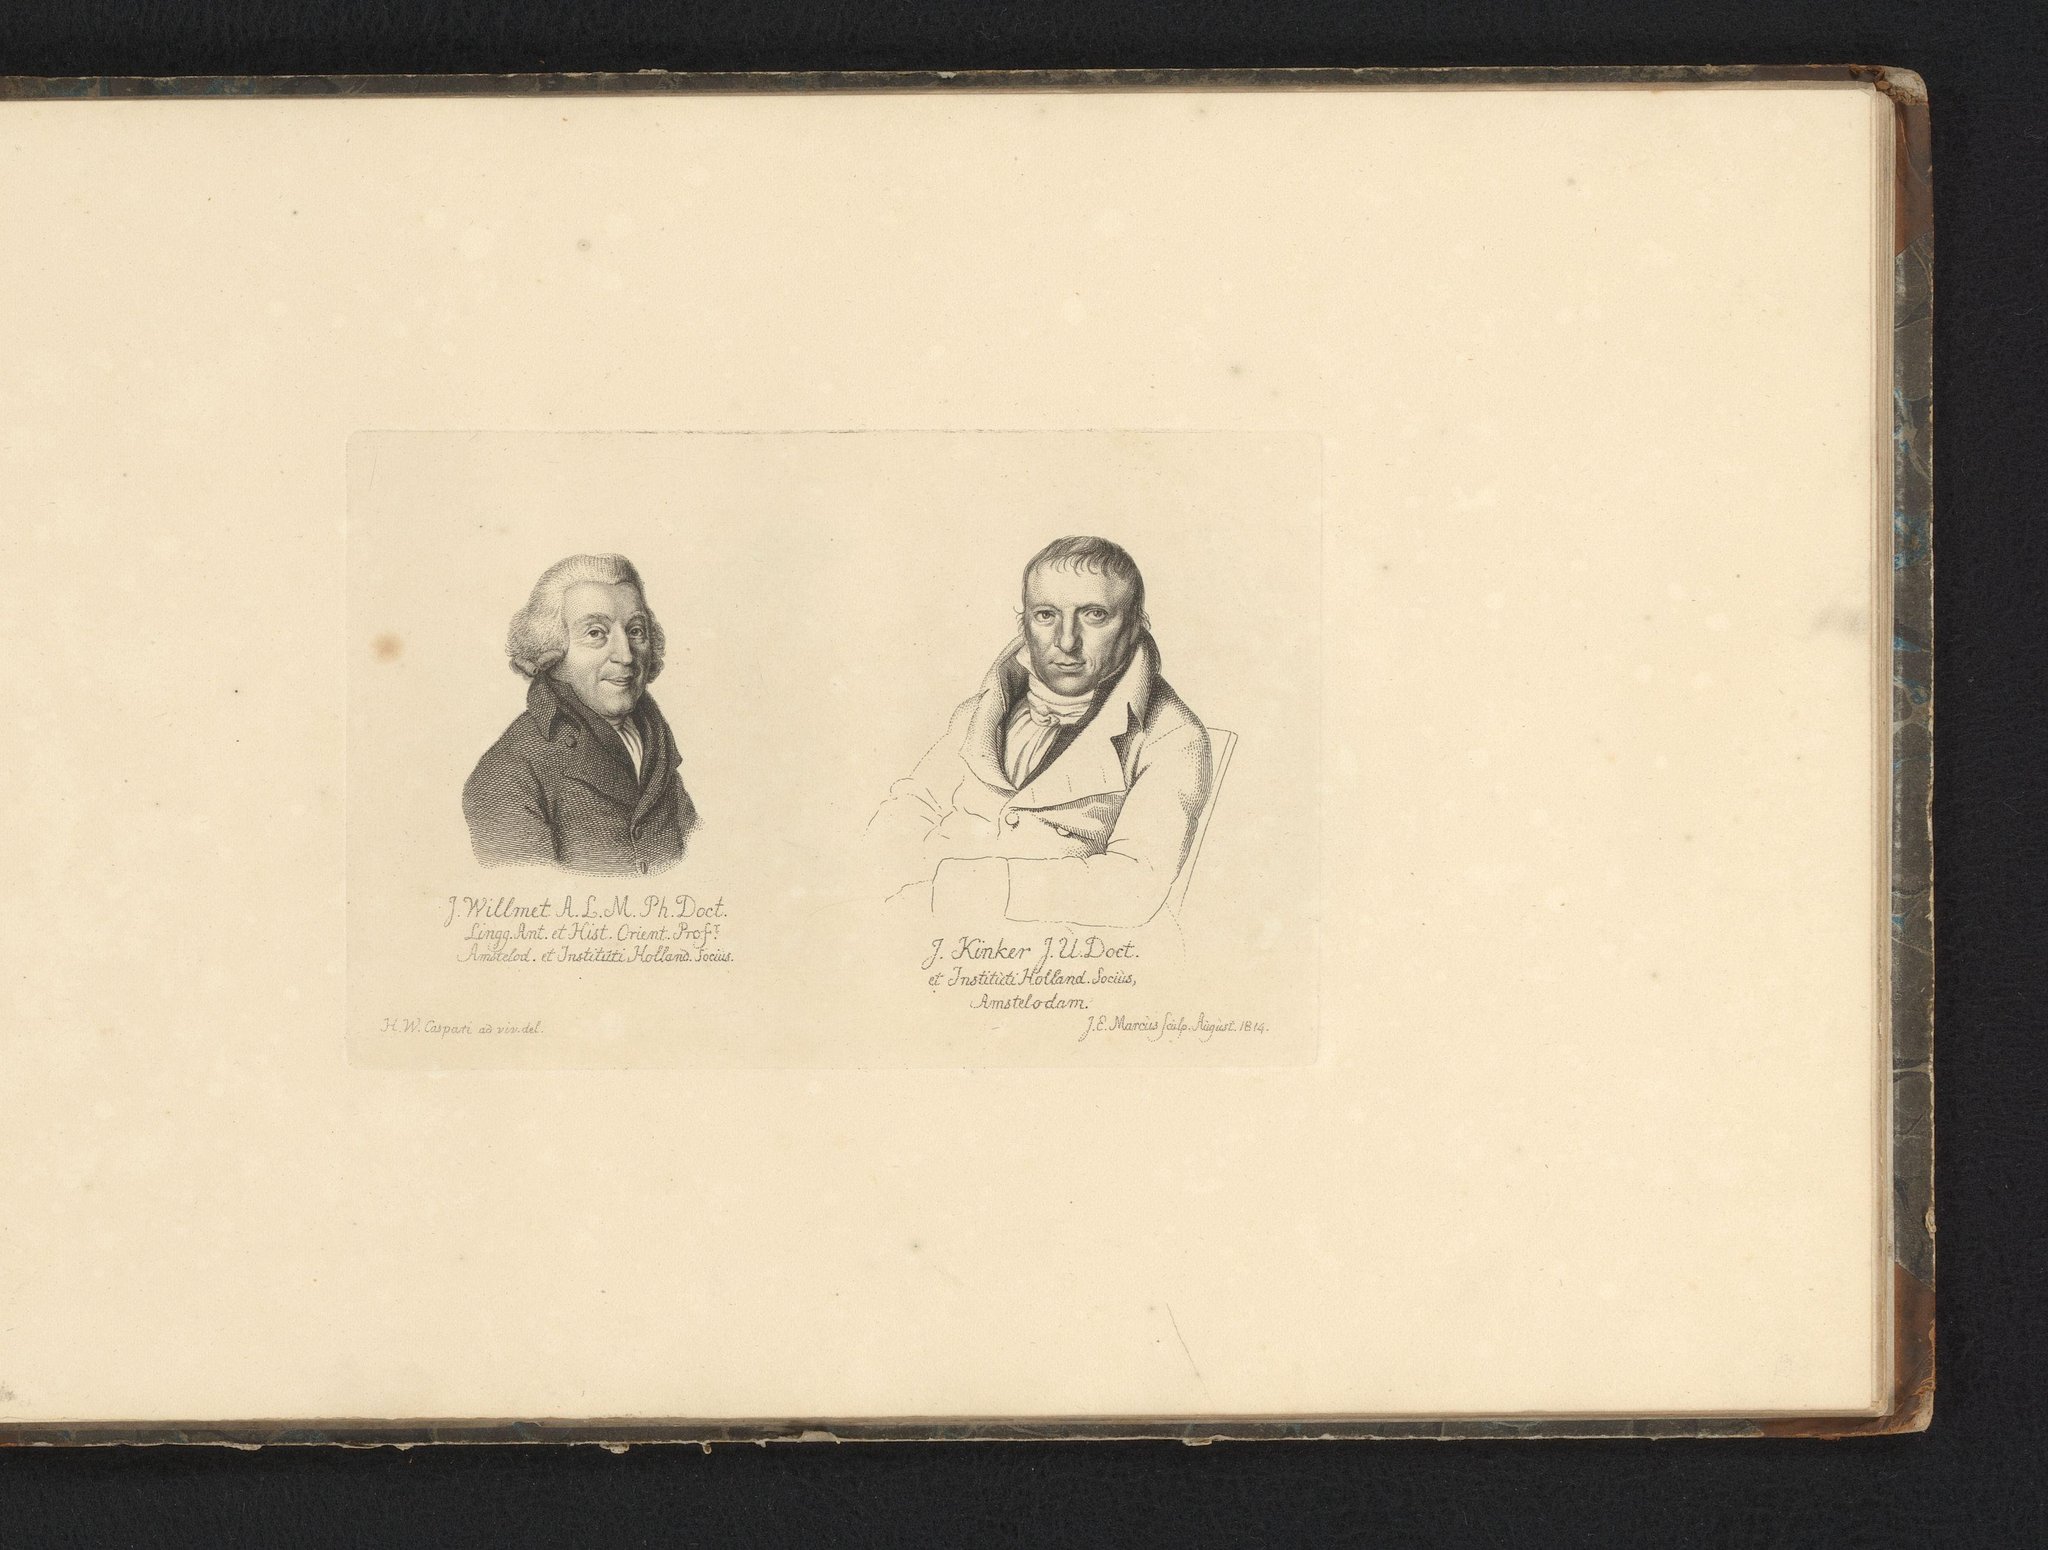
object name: print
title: Studiebeelden en fragmenten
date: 1808-1814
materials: paper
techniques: etching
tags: johannes kinker, amsterdam, historical persons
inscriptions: date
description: Deze prent maakt deel uit van een album.